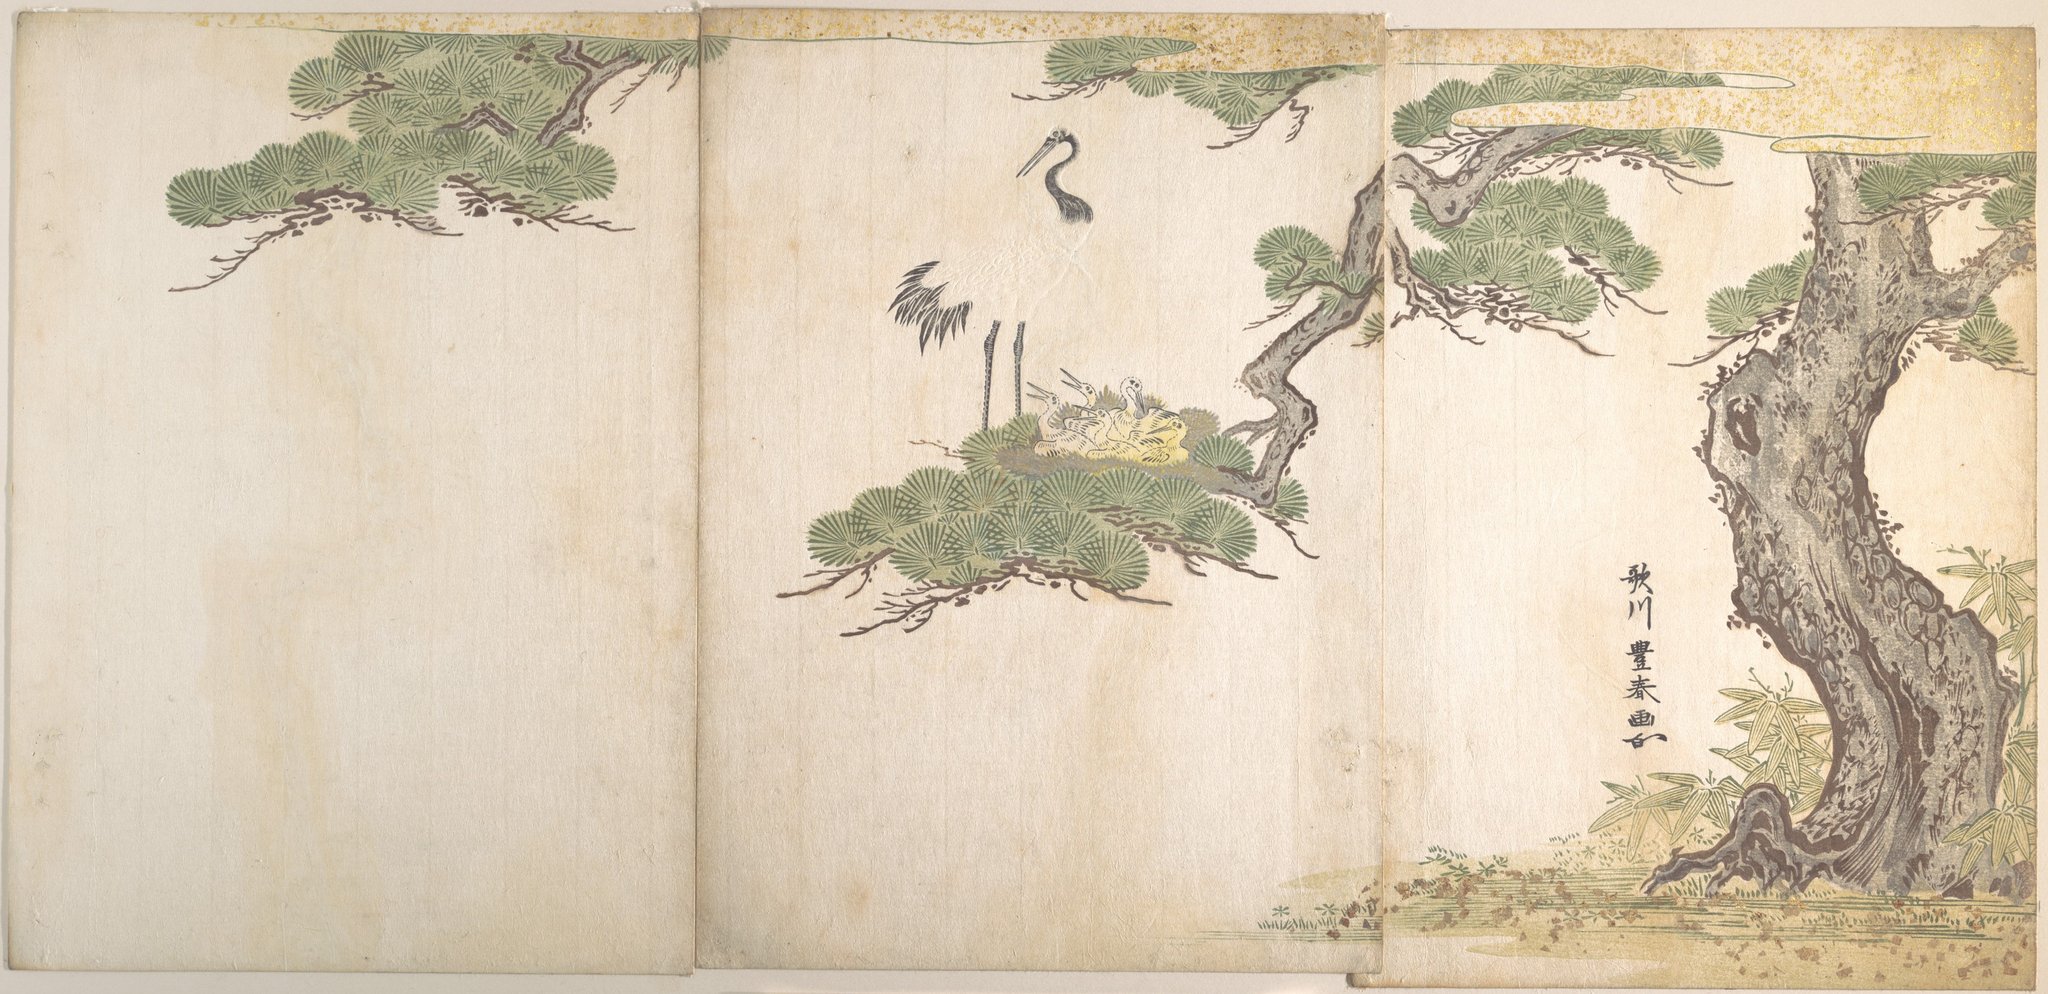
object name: woodblock print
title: Crane and Their Young in Their Nest in the Branches of a Pine-tree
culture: japanese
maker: utagawa toyoharu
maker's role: artist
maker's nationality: japanese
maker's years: 1735-1814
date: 1790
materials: ink, paper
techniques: surimono, woodblock print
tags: cranes,trees